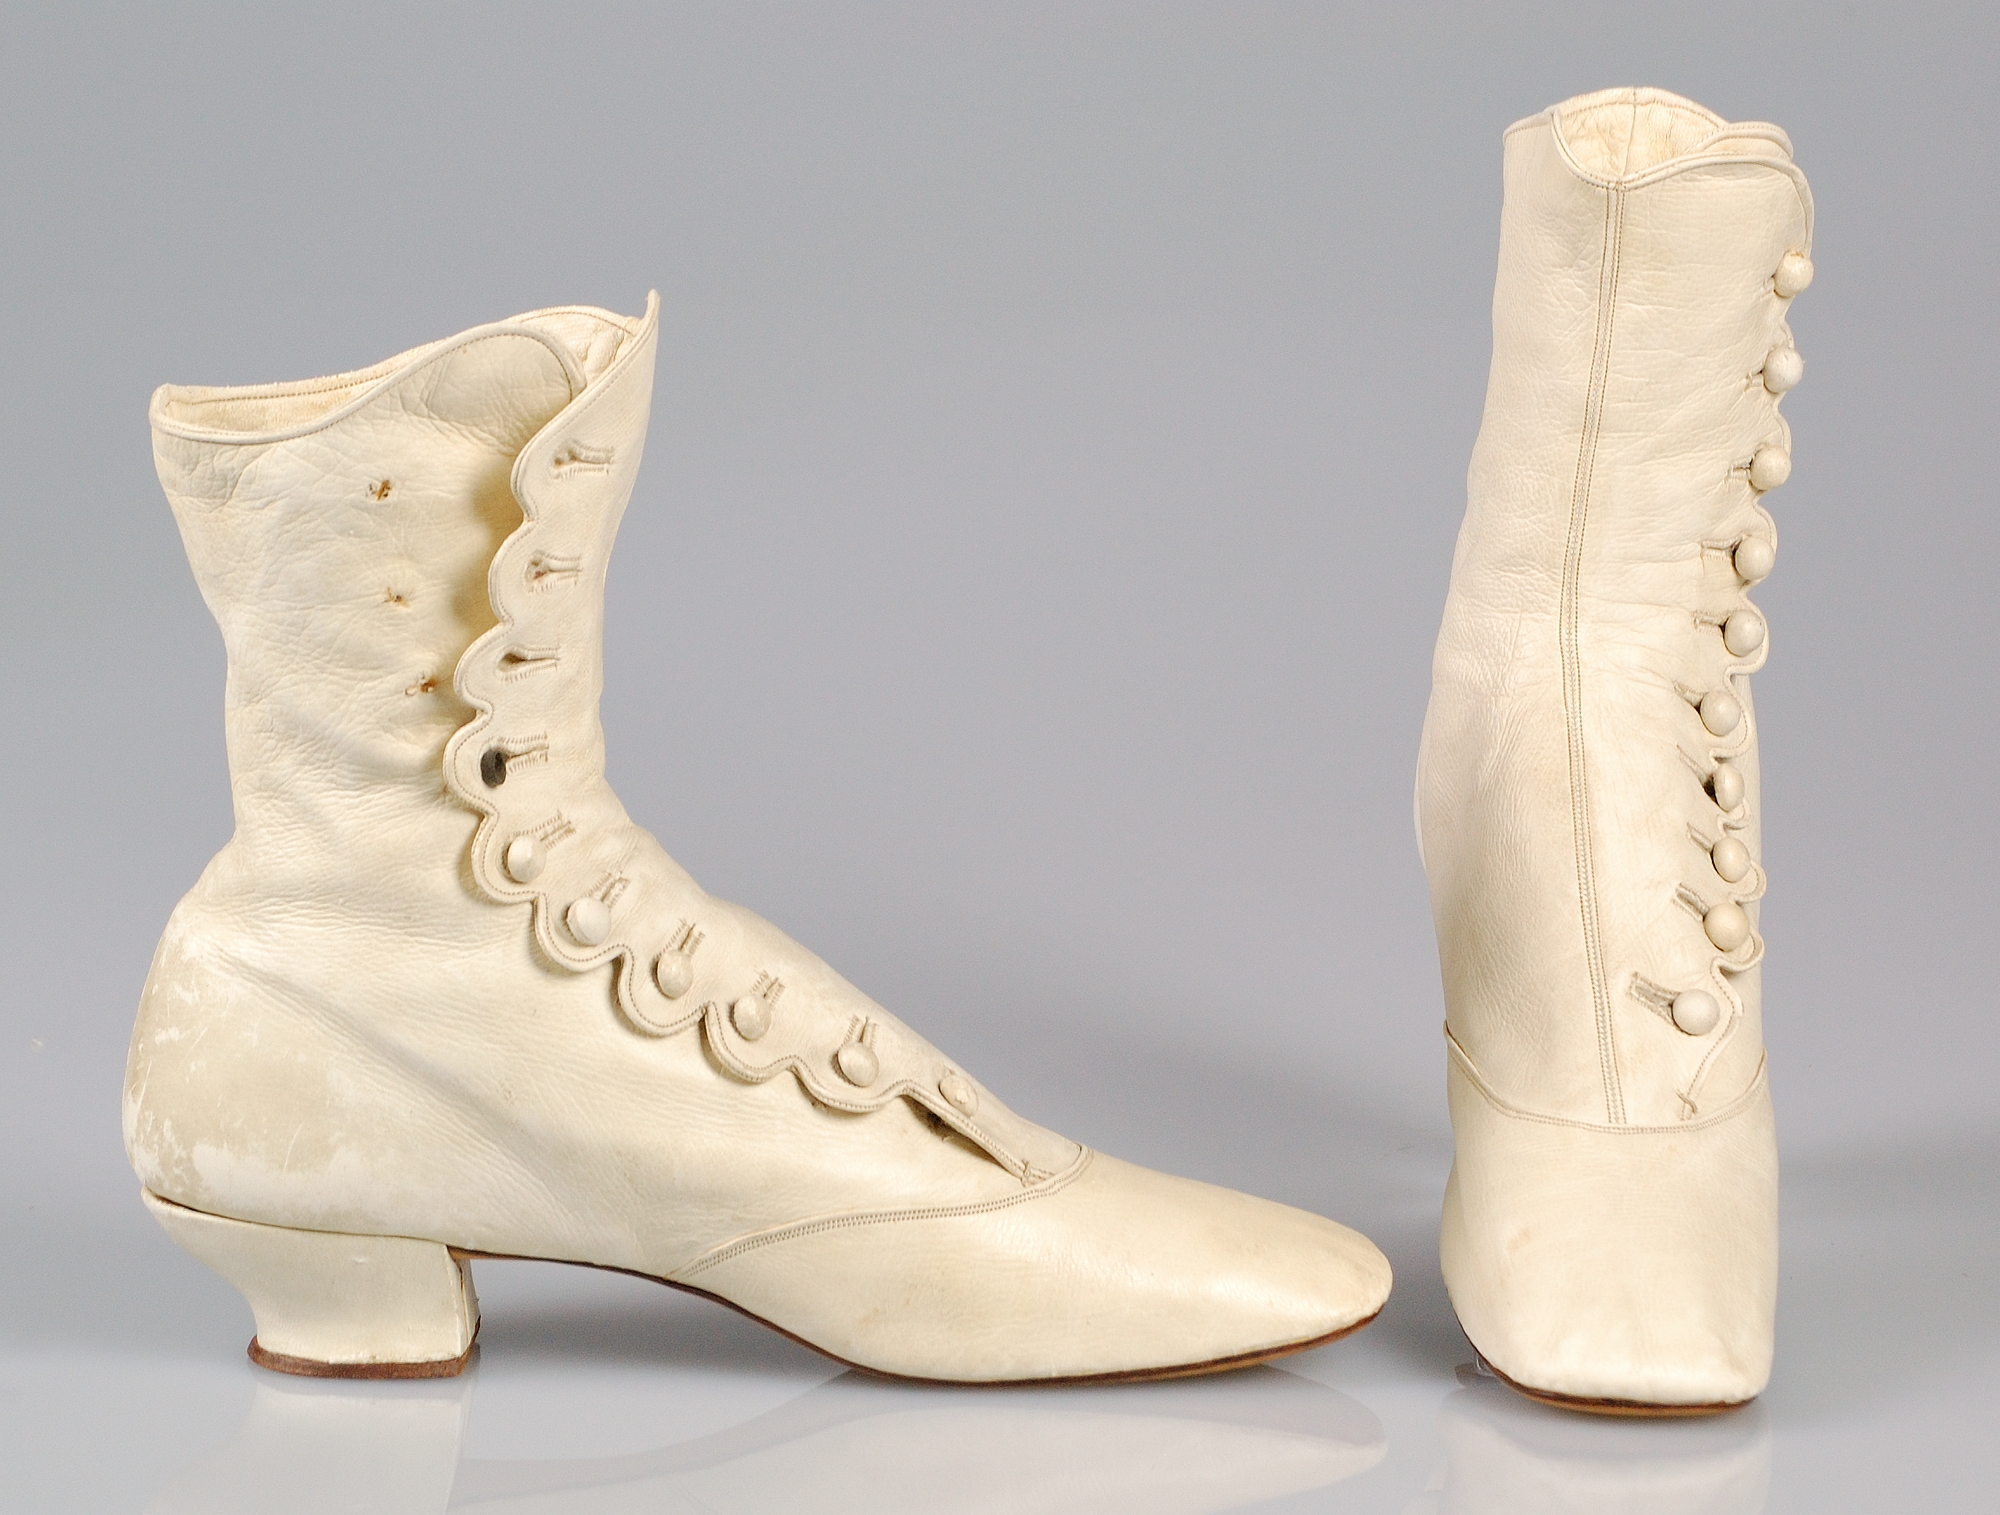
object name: wedding boot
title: Wedding boots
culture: american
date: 1875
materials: leather